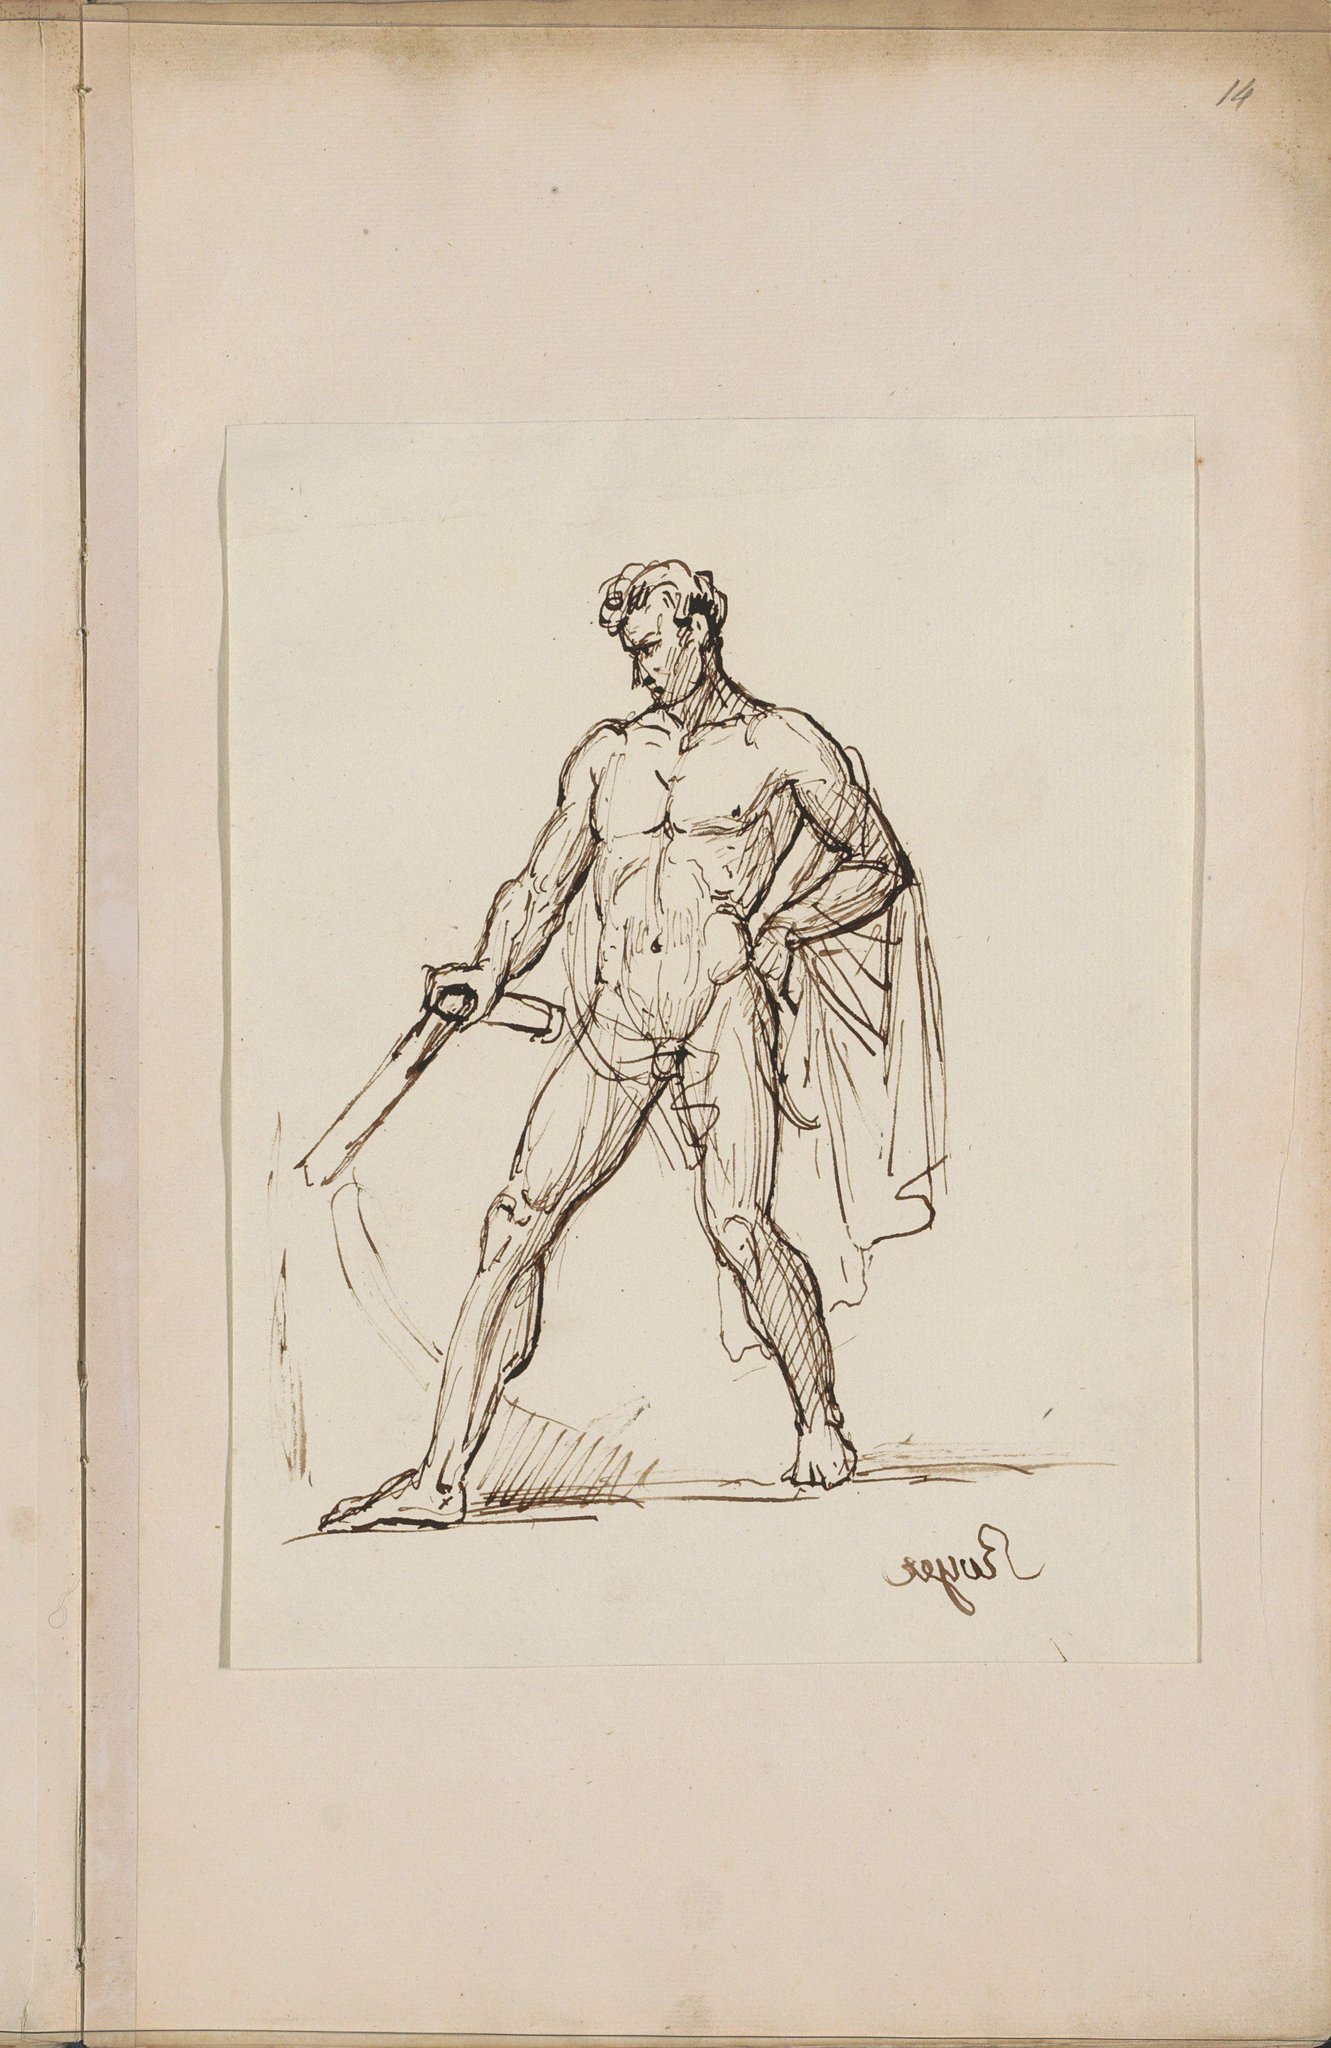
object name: album leaf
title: Naakte man met een cape en zwaard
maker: louis royer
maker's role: draughtsman, sculptor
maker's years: 1793-1868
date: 1843-1864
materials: ink, paper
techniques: pen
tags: the (nude) human figure; 'corpo humano' (ripa), cape, hacking and thrusting weapons: sword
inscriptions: annotation: ‘maandag 2 oktober. aangifte der leerlingen der AK.’, signature: ‘Royer’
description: Blad 14 recto uit een verzamelalbum met 32 bladen.